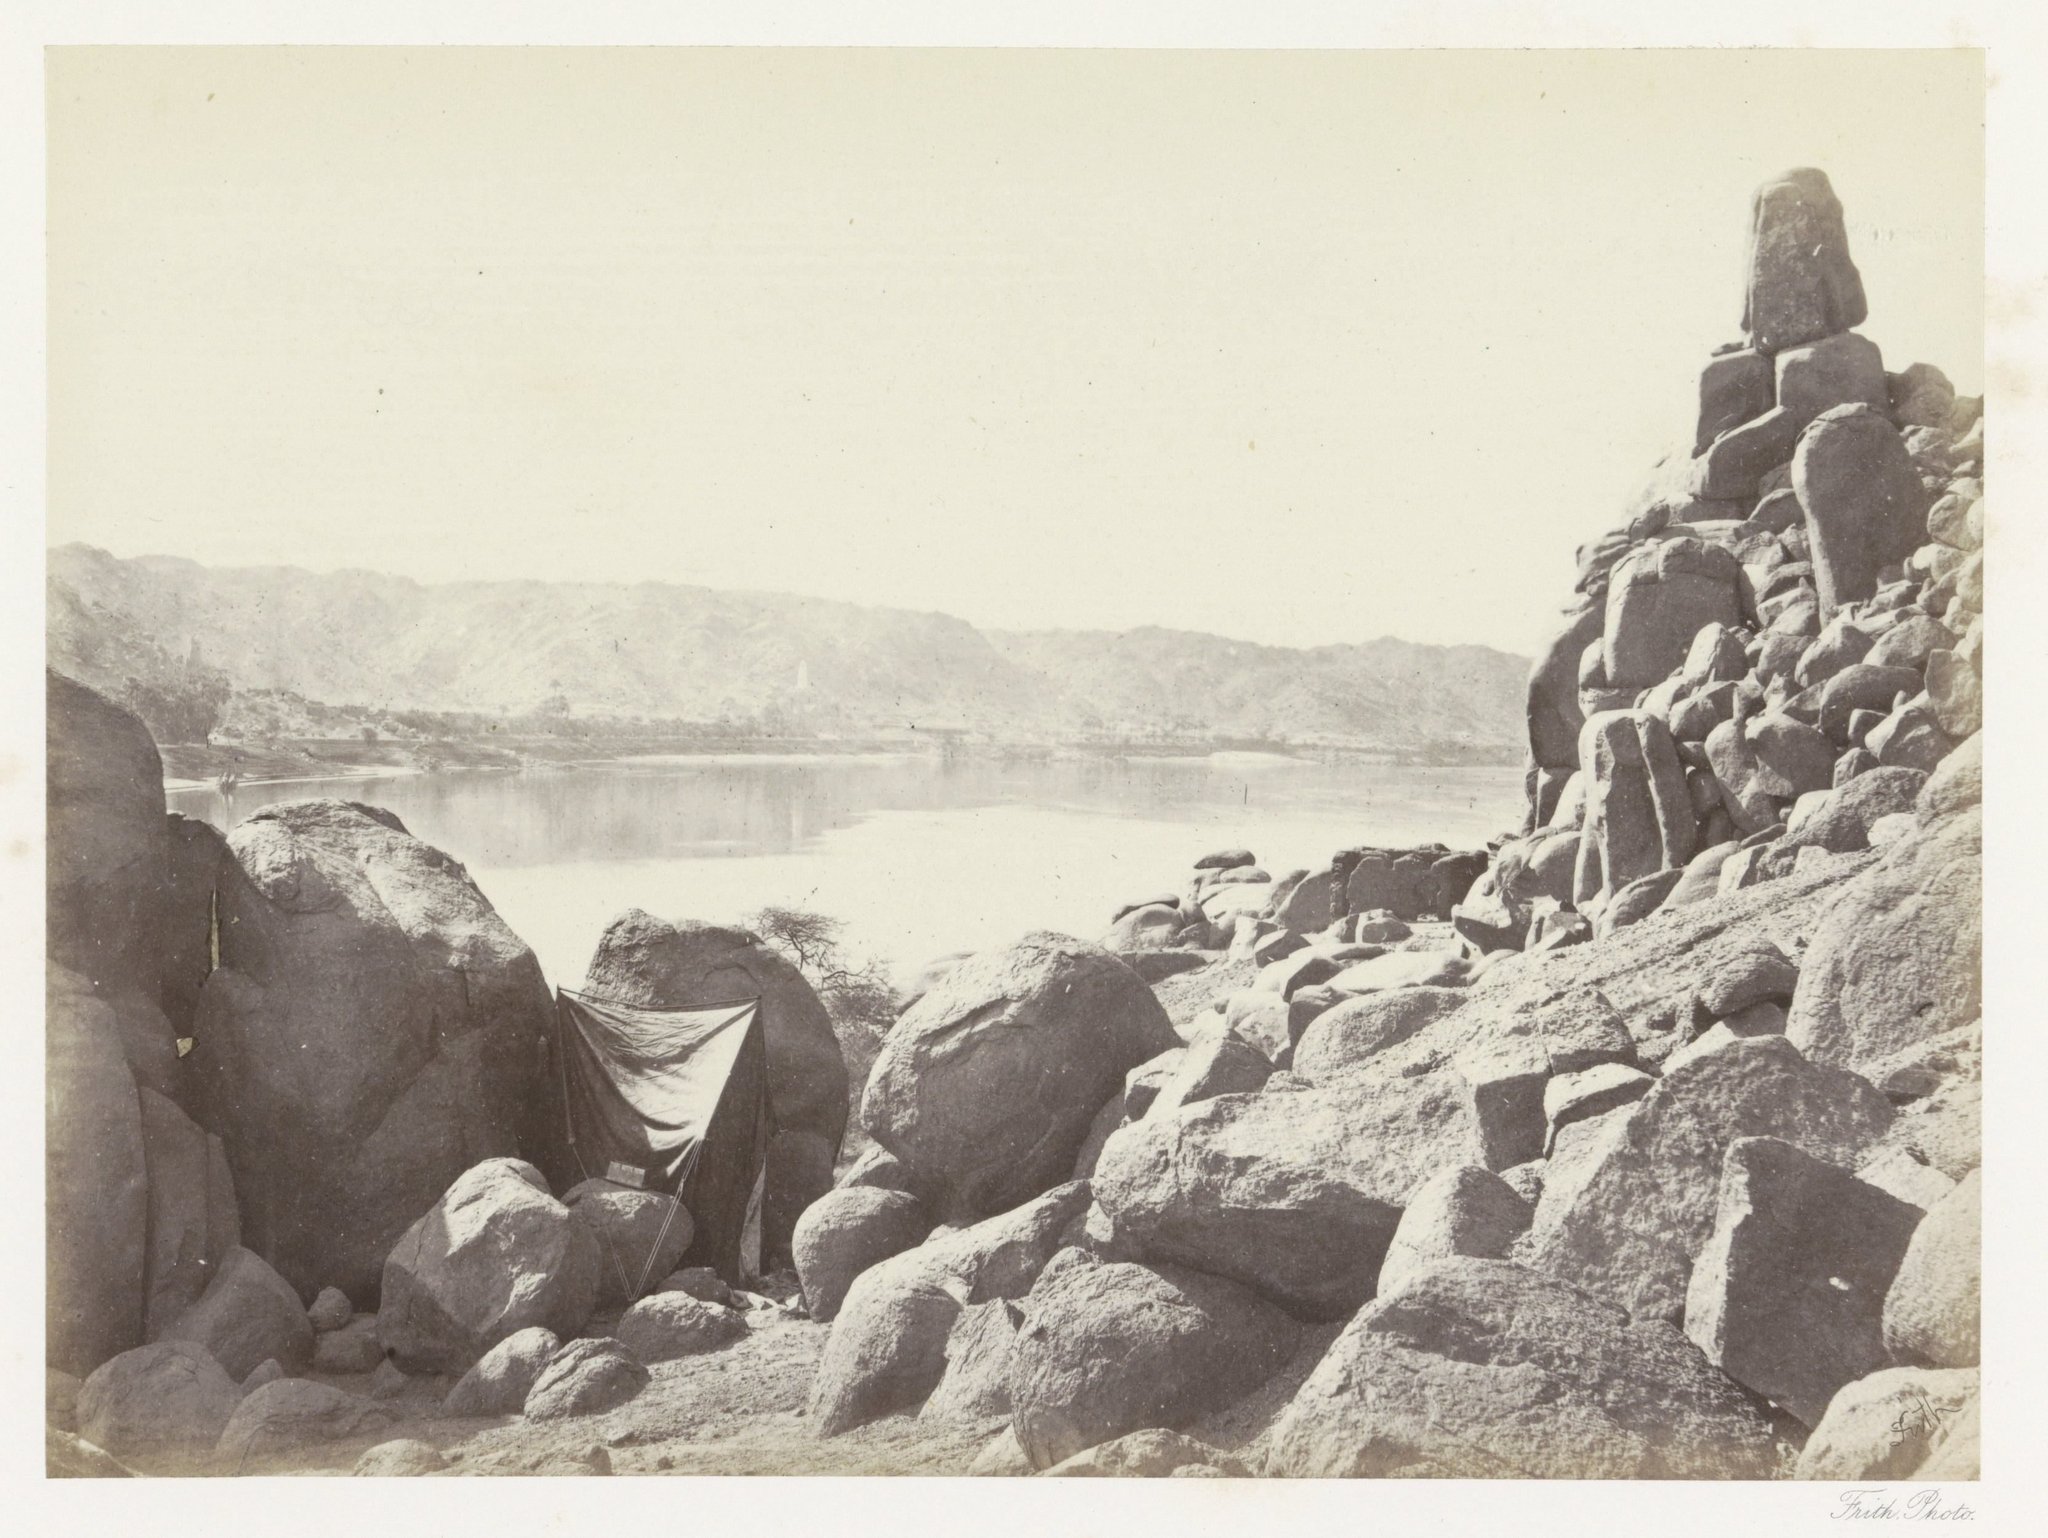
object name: page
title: View from the island of Biggeh - Looking South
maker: francis frith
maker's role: publisher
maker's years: 1822-1898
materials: paper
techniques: albumen print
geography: bigeh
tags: island, river